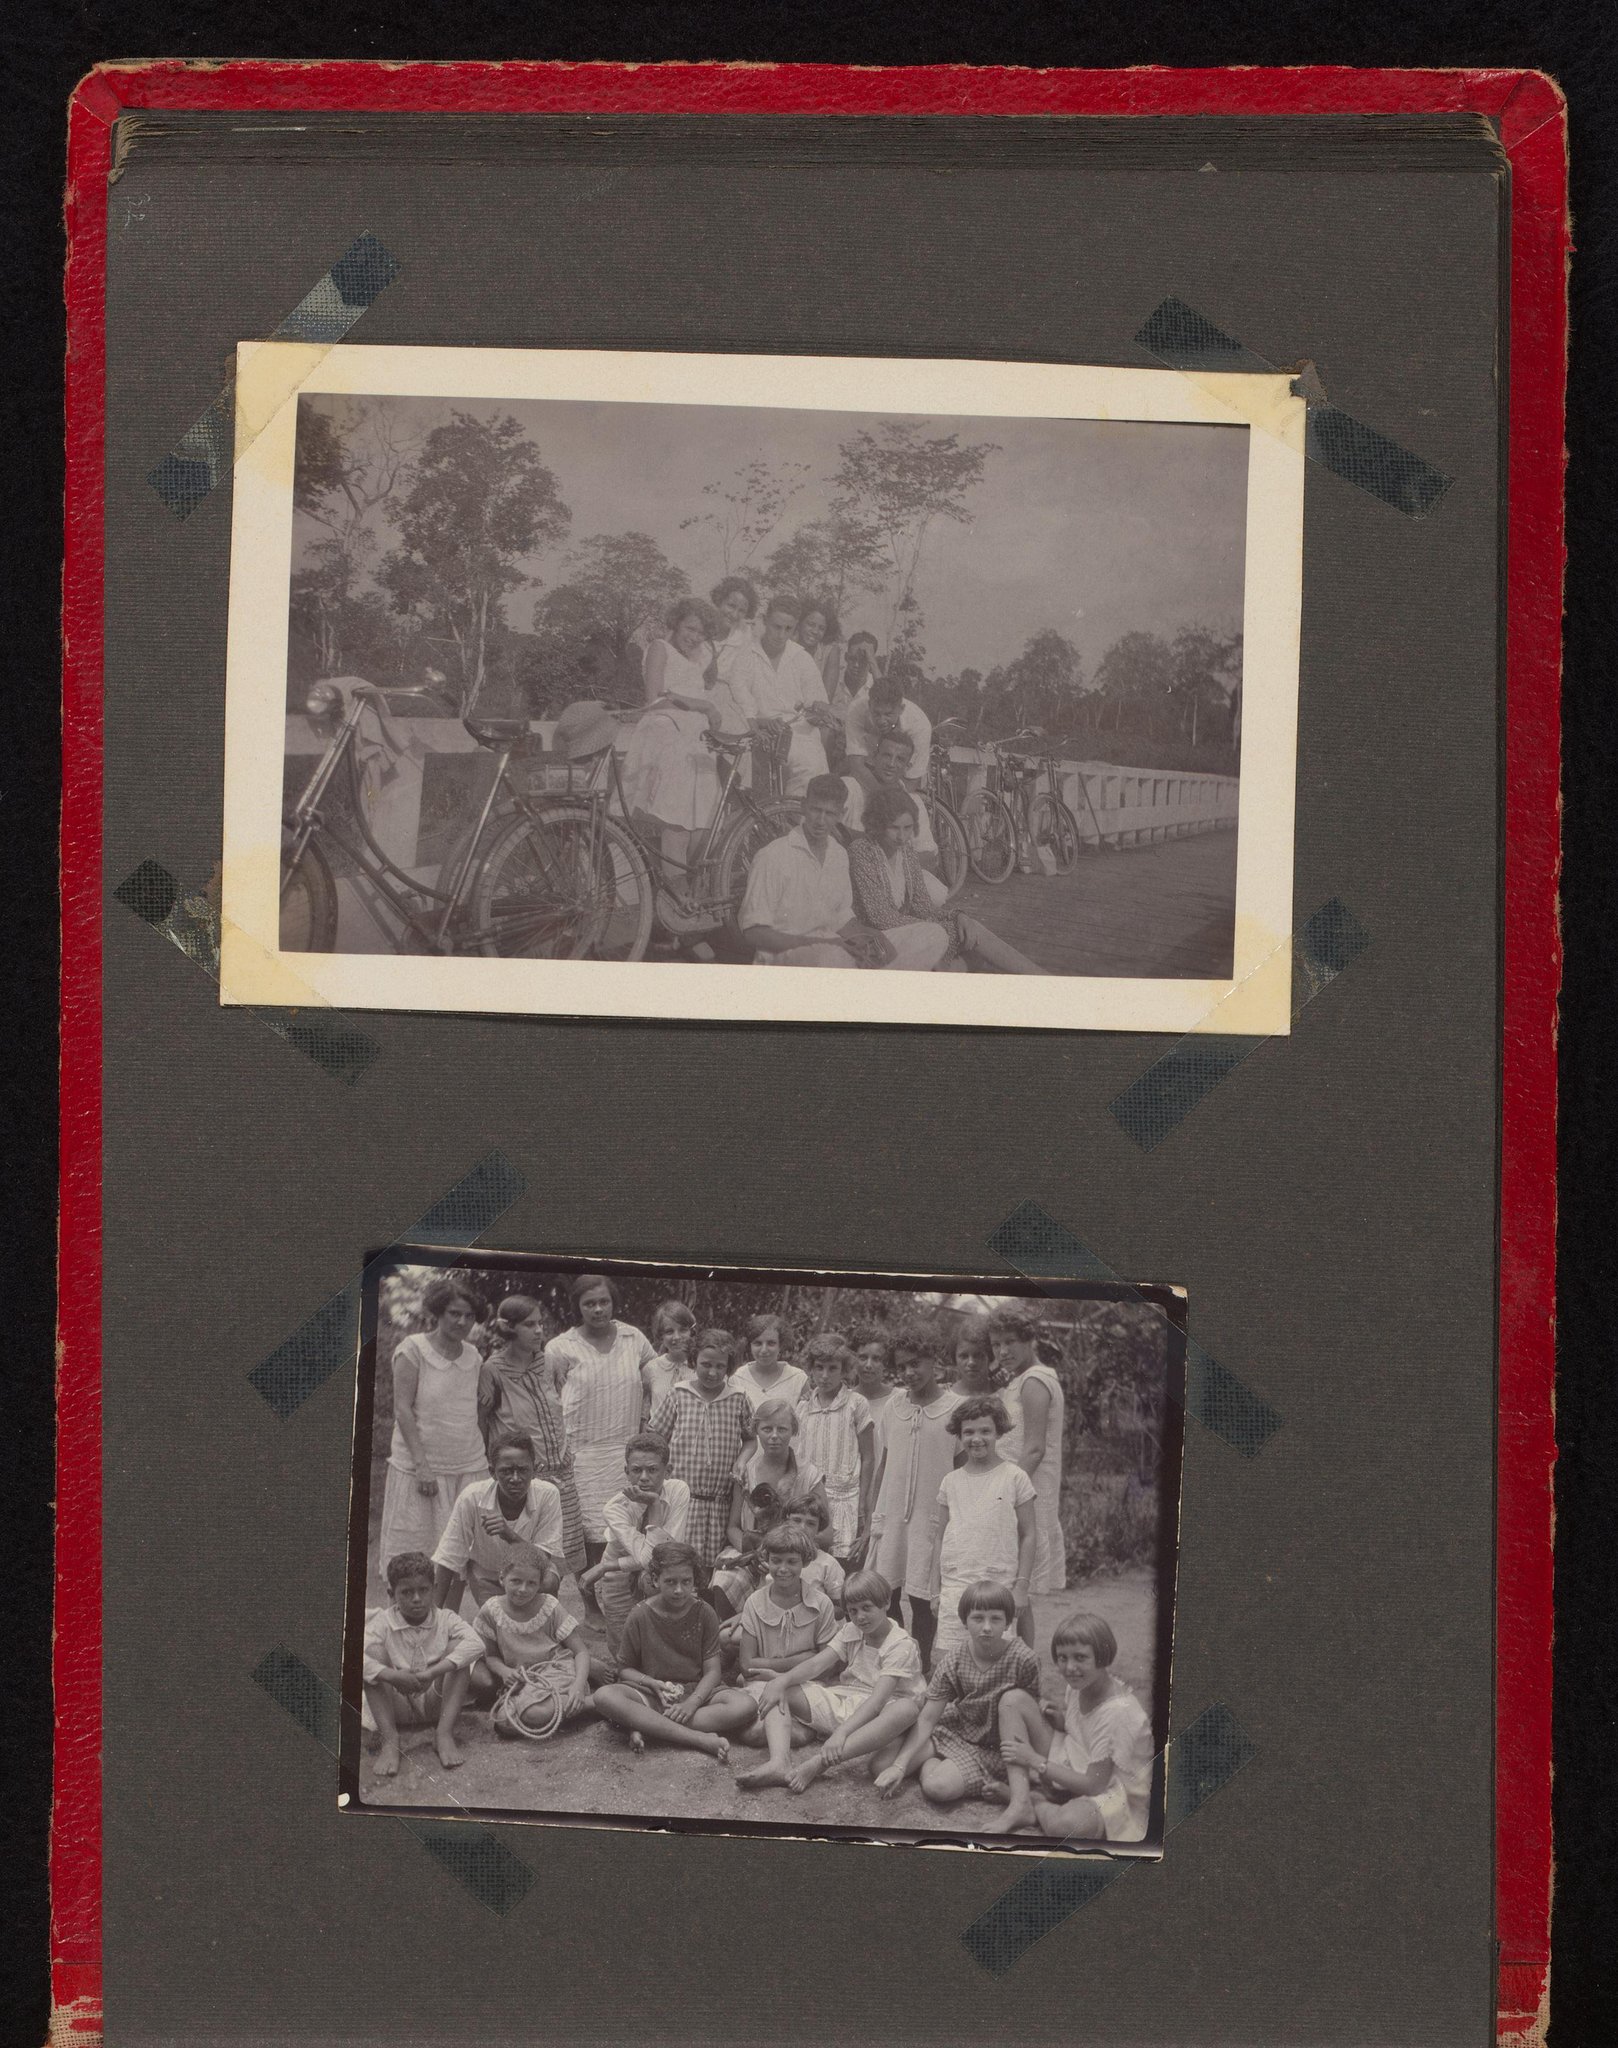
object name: album leaf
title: Groepsfoto's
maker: Anonymous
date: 1925-1935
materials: paper, photographic support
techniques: collodion silver print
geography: suriname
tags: bicycle, anonymous historical persons portrayed in a group, in a group-portrait, suriname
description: Albumblad met twee groepsfoto's van een groep jonge mensen met fietsen en van een groep jongere en oudere kinderen staand en zittend op de grond, in Suriname. Onderdeel van het fotoalbum van Theodoor Brouwers over Suriname ca. 1930.